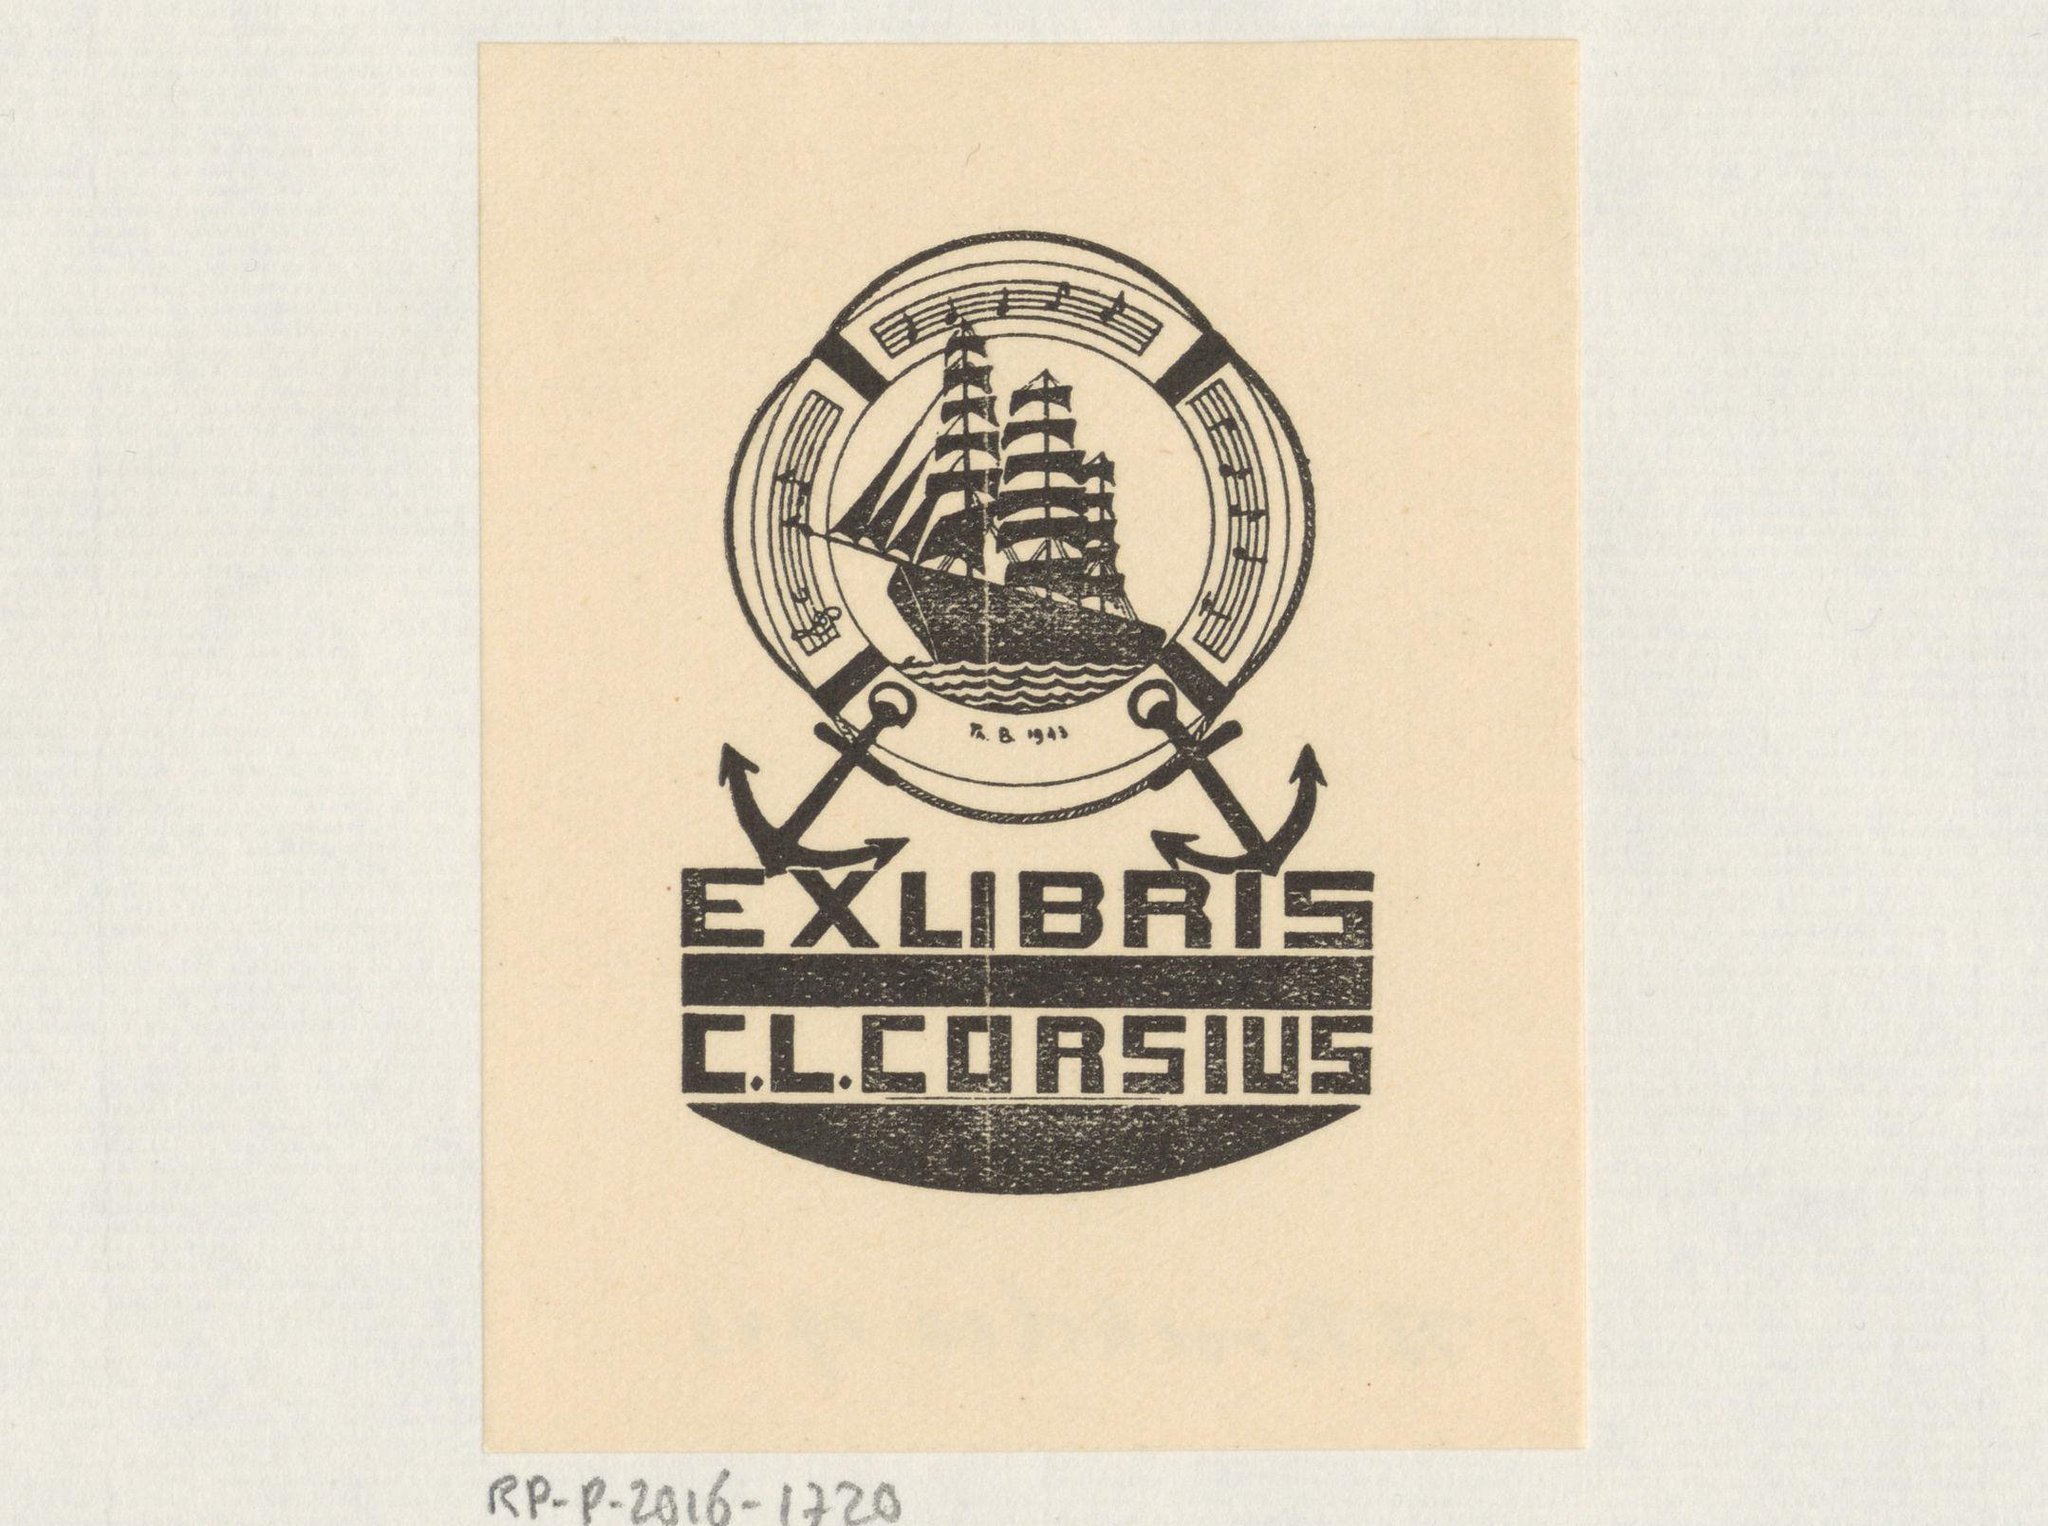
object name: bookplate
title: Ex libris van C.L. Corsius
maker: theo broekstra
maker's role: print maker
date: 1943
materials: paper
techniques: printing block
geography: netherlands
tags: notation of music, sailing-ship, sailing-boat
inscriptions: date